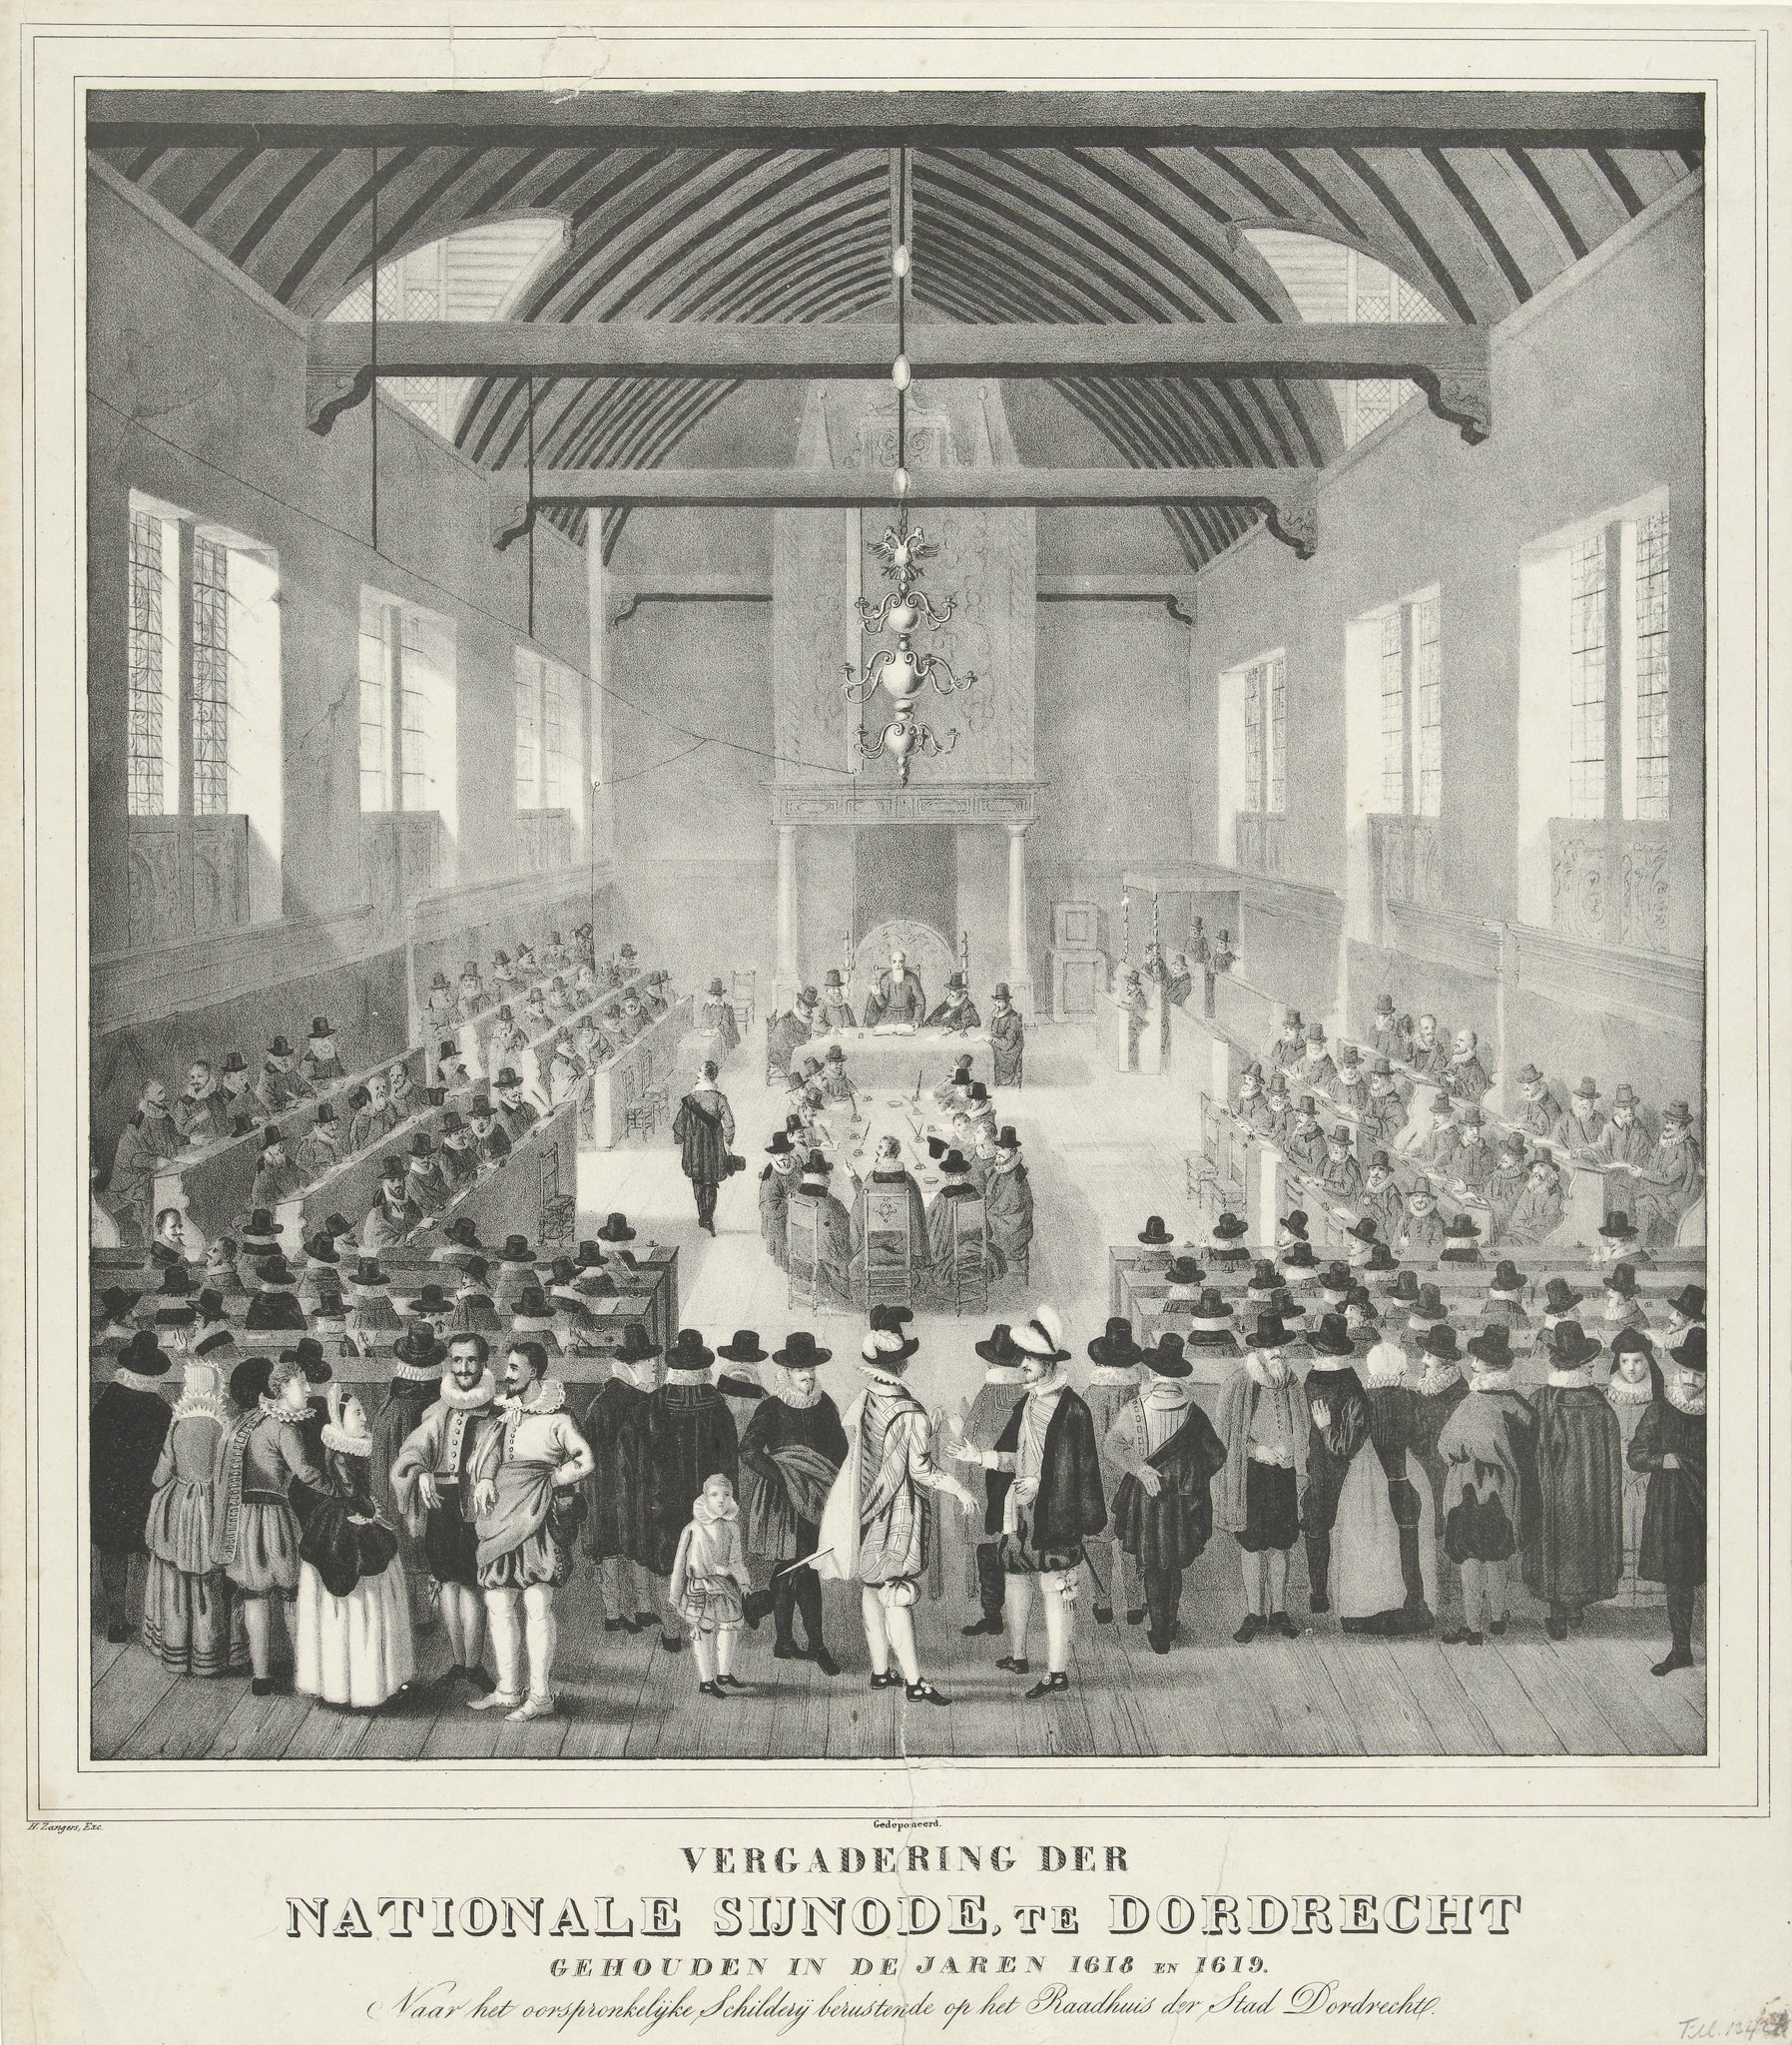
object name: print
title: Opening van de Nationale Synode te Dordrecht, 1618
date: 1800-1899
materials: paper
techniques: lithograph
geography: netherlands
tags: organizations, assemblies, etc. in protestant churches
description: Vermeld op de prent: Naar het oorspronkelijke Schilderij berustende op het Raadhuis der Stad Dordrecht. Dit is het schilderij toegeschreven aan Pouwels Weyts (II) gedateerd 1621 op het stadhuis van Dordrecht. Het schilderij is gebaseerd op de vroegere prent van François Schillemans uit 1618-1619.